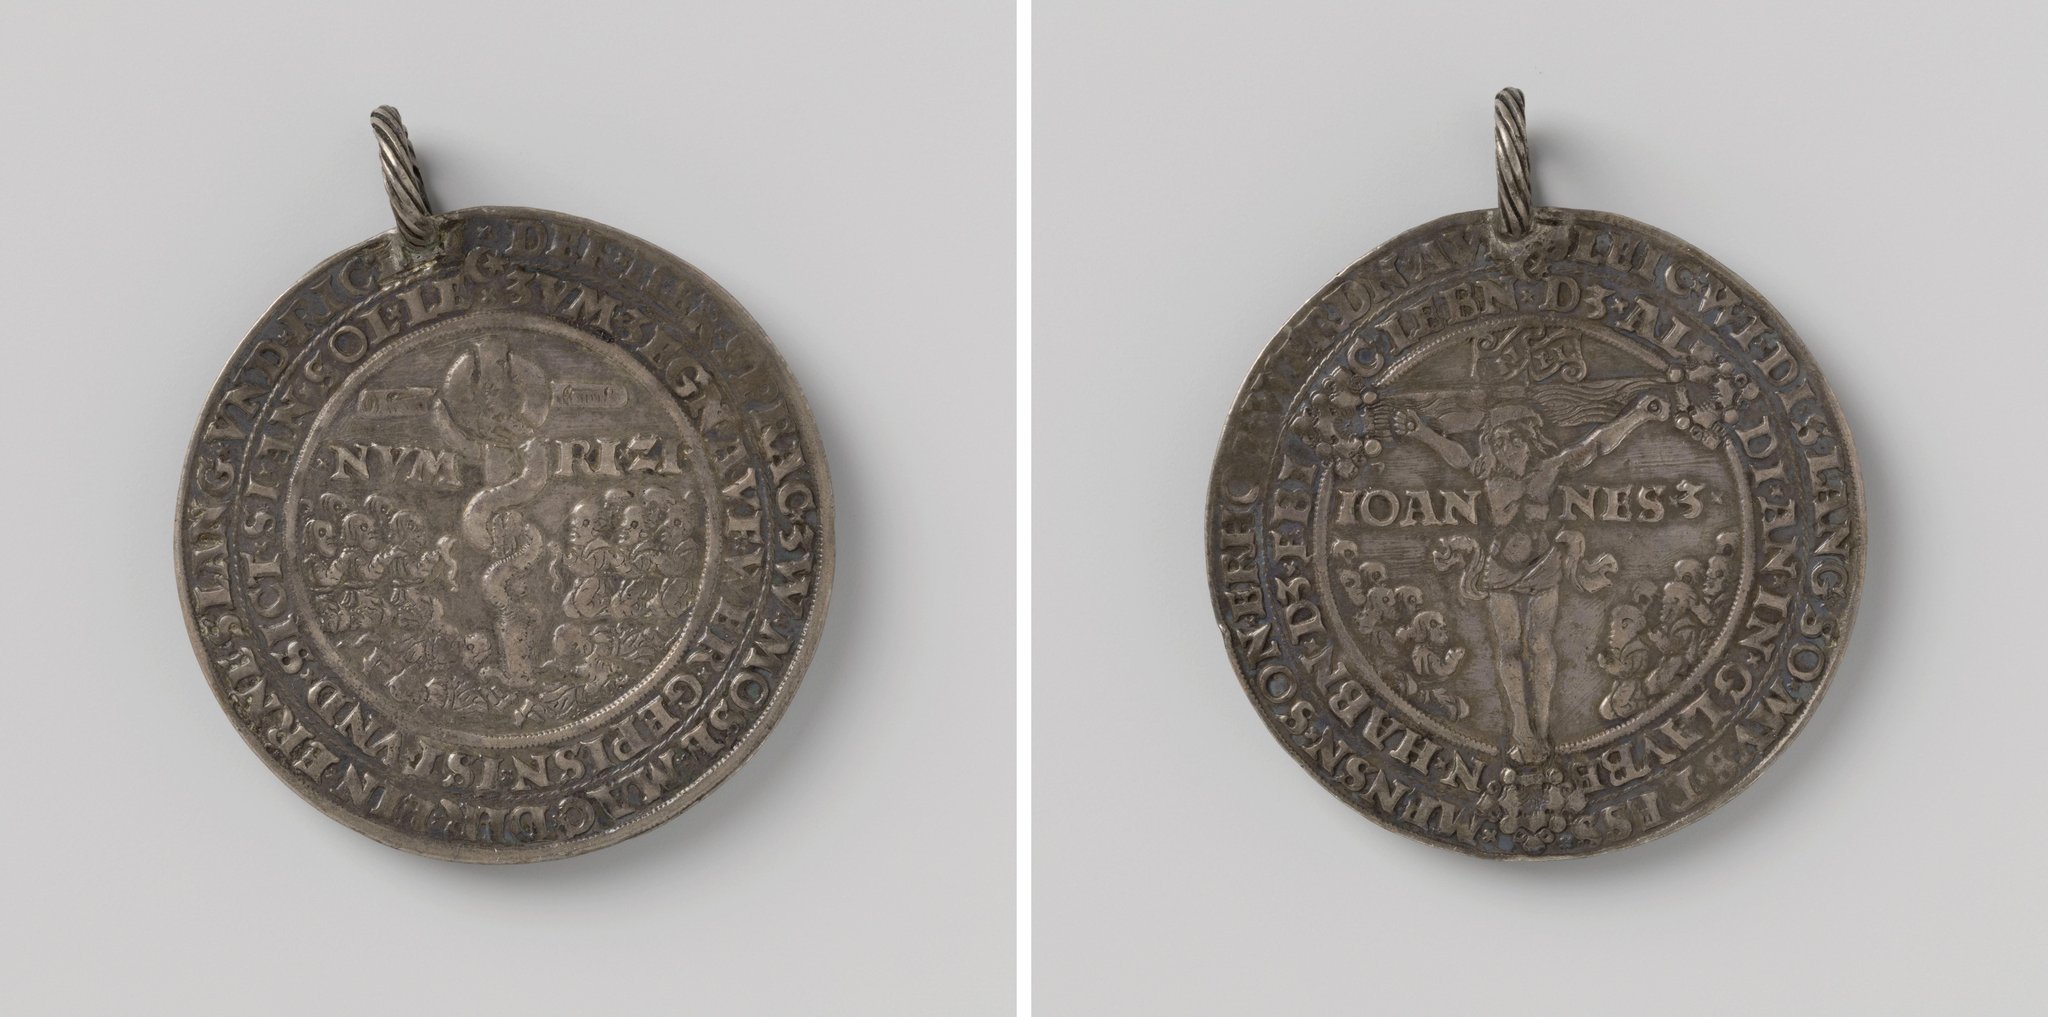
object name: history medal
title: Pest in Duitsland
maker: ulrich gebhart (utz)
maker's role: die cutter, mintmaster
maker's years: 1479-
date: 1528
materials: silver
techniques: striking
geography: jàchymov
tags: mintmaster, die cutter, ulrich gebhart (utz), a serpent of brass is made and is set on a pole, the crucifixion of christ: christ's death on the cross; golgotha (matthew 27:45-58; mark 15:33-45; luke 23:44-52; john 19:25-38), germany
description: Zilveren penning met draagoog. Voorzijde: koperen slang om kruis, daaromheen knielende Israelieten binnen tweeregelig omschrift. Keerzijde: Christus aan kruis, daaromheen knielende Israelieten binnen tweeregelig omschrift